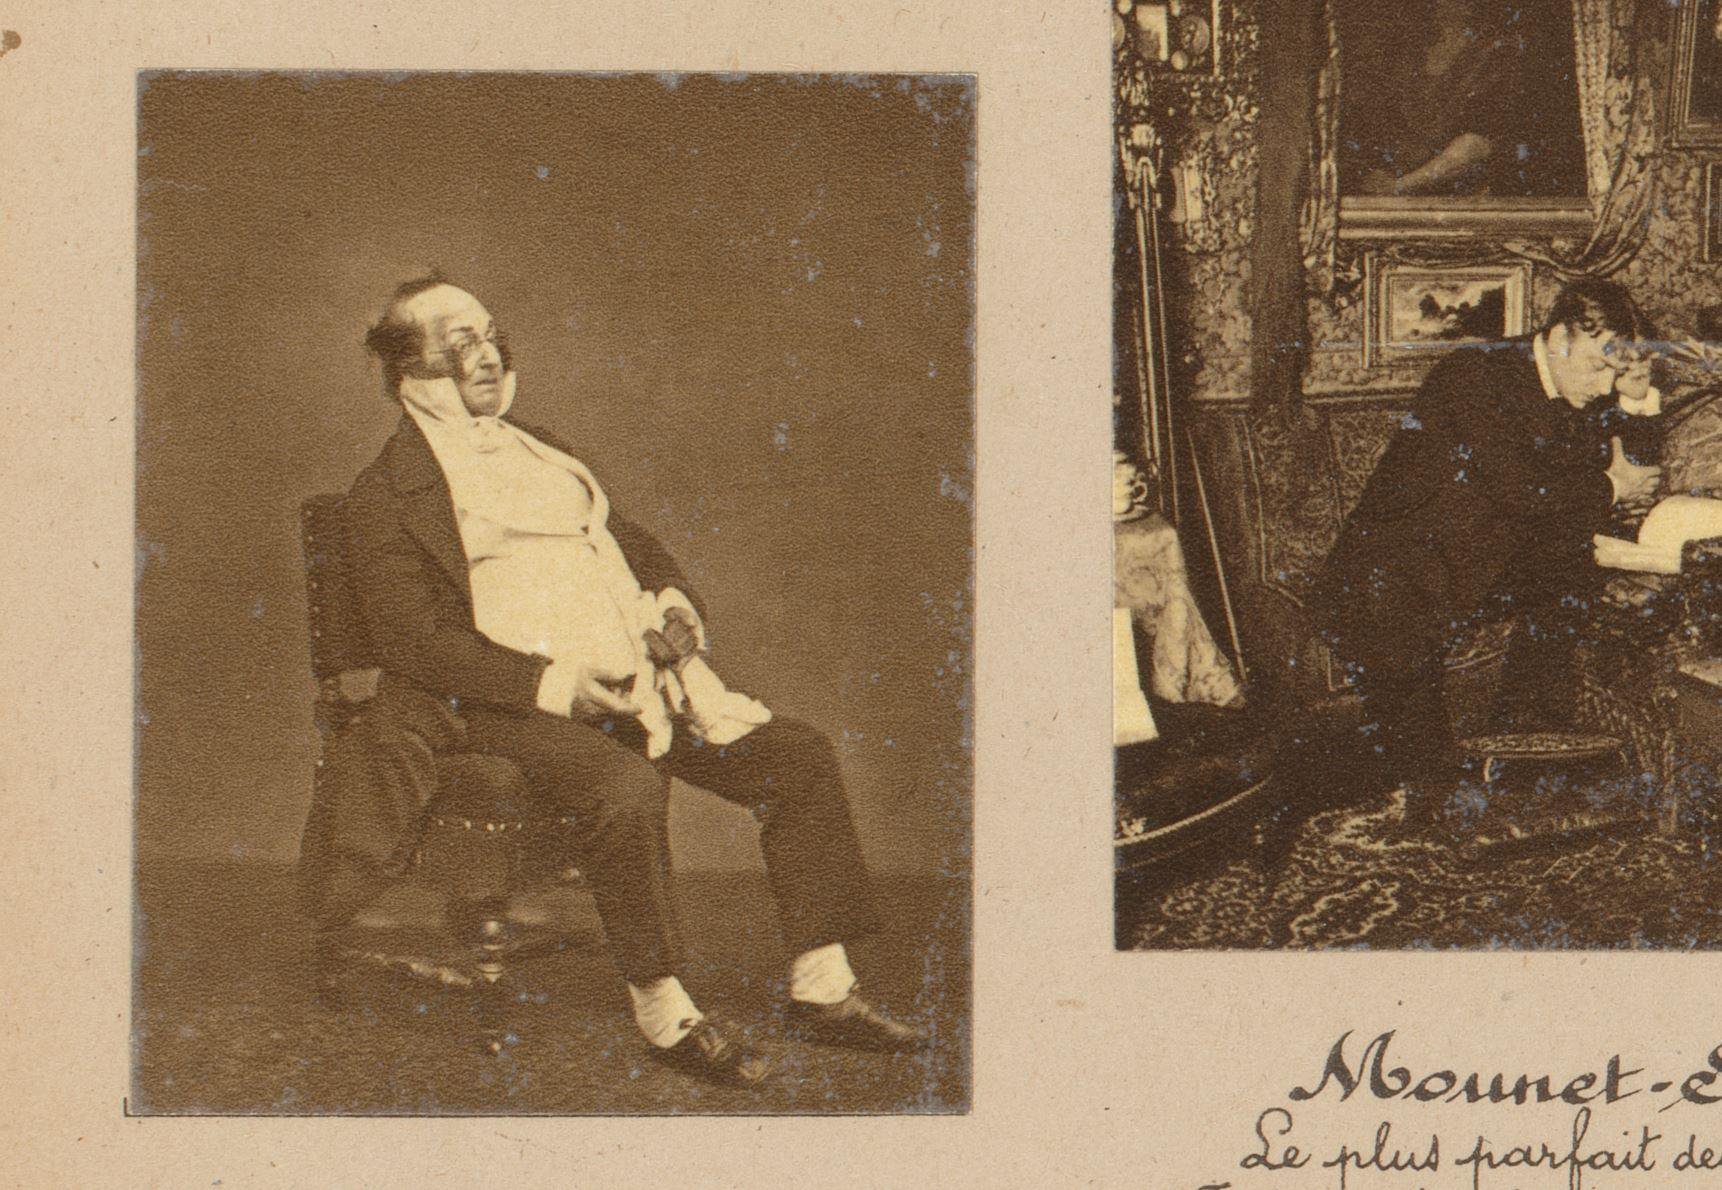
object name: photograph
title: Henry Monnier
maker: étienne carjat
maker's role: draughtsman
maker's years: 1828-1906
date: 1875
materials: paper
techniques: rotogravure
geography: france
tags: paris, print maker, draughtsman, henry bonaventure monnier, portrait of actor, actress, france